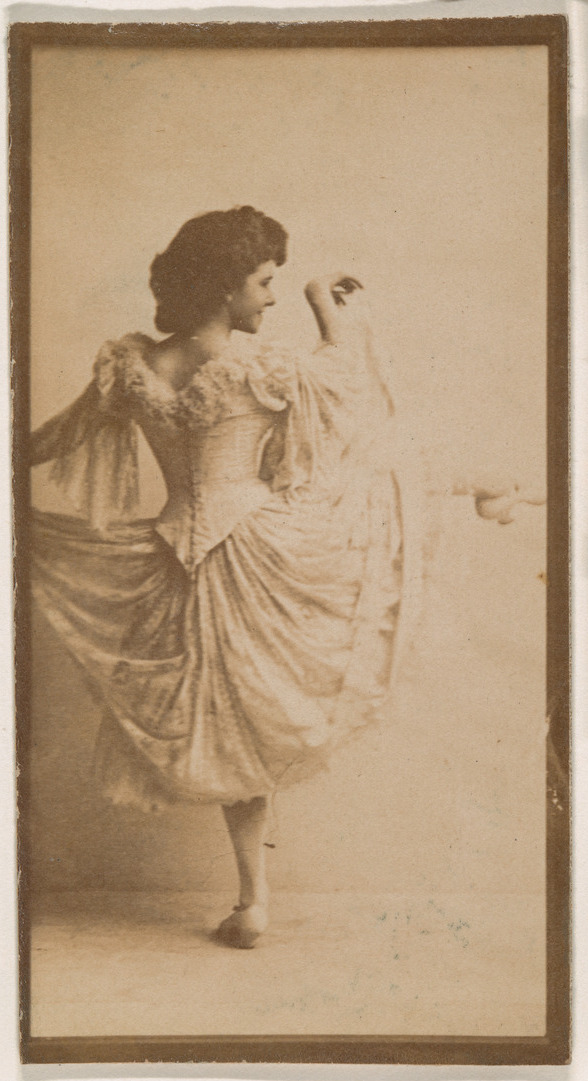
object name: photograph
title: Dancer, from the Actresses series (N664) promoting Old Fashion Fine Cut Tobacco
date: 1888-1890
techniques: albumen silver print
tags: portraits,women,dancers